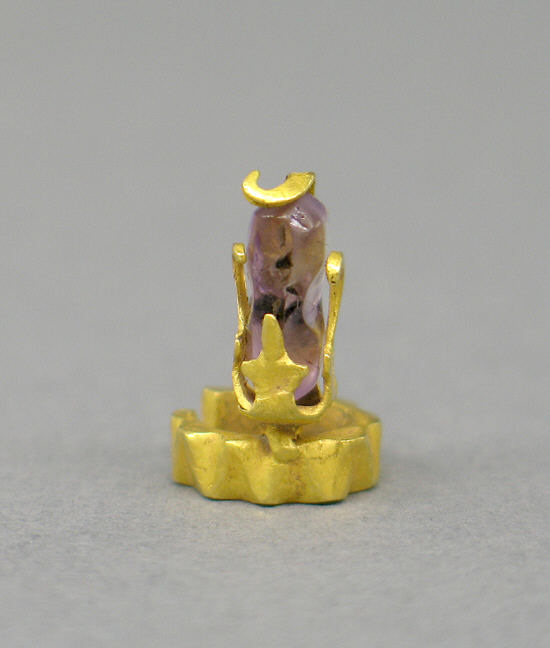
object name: ear clip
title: Pair of Ear Clips with Purple Stones in Tendril Mount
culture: indonesian, javanese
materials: gold, stone